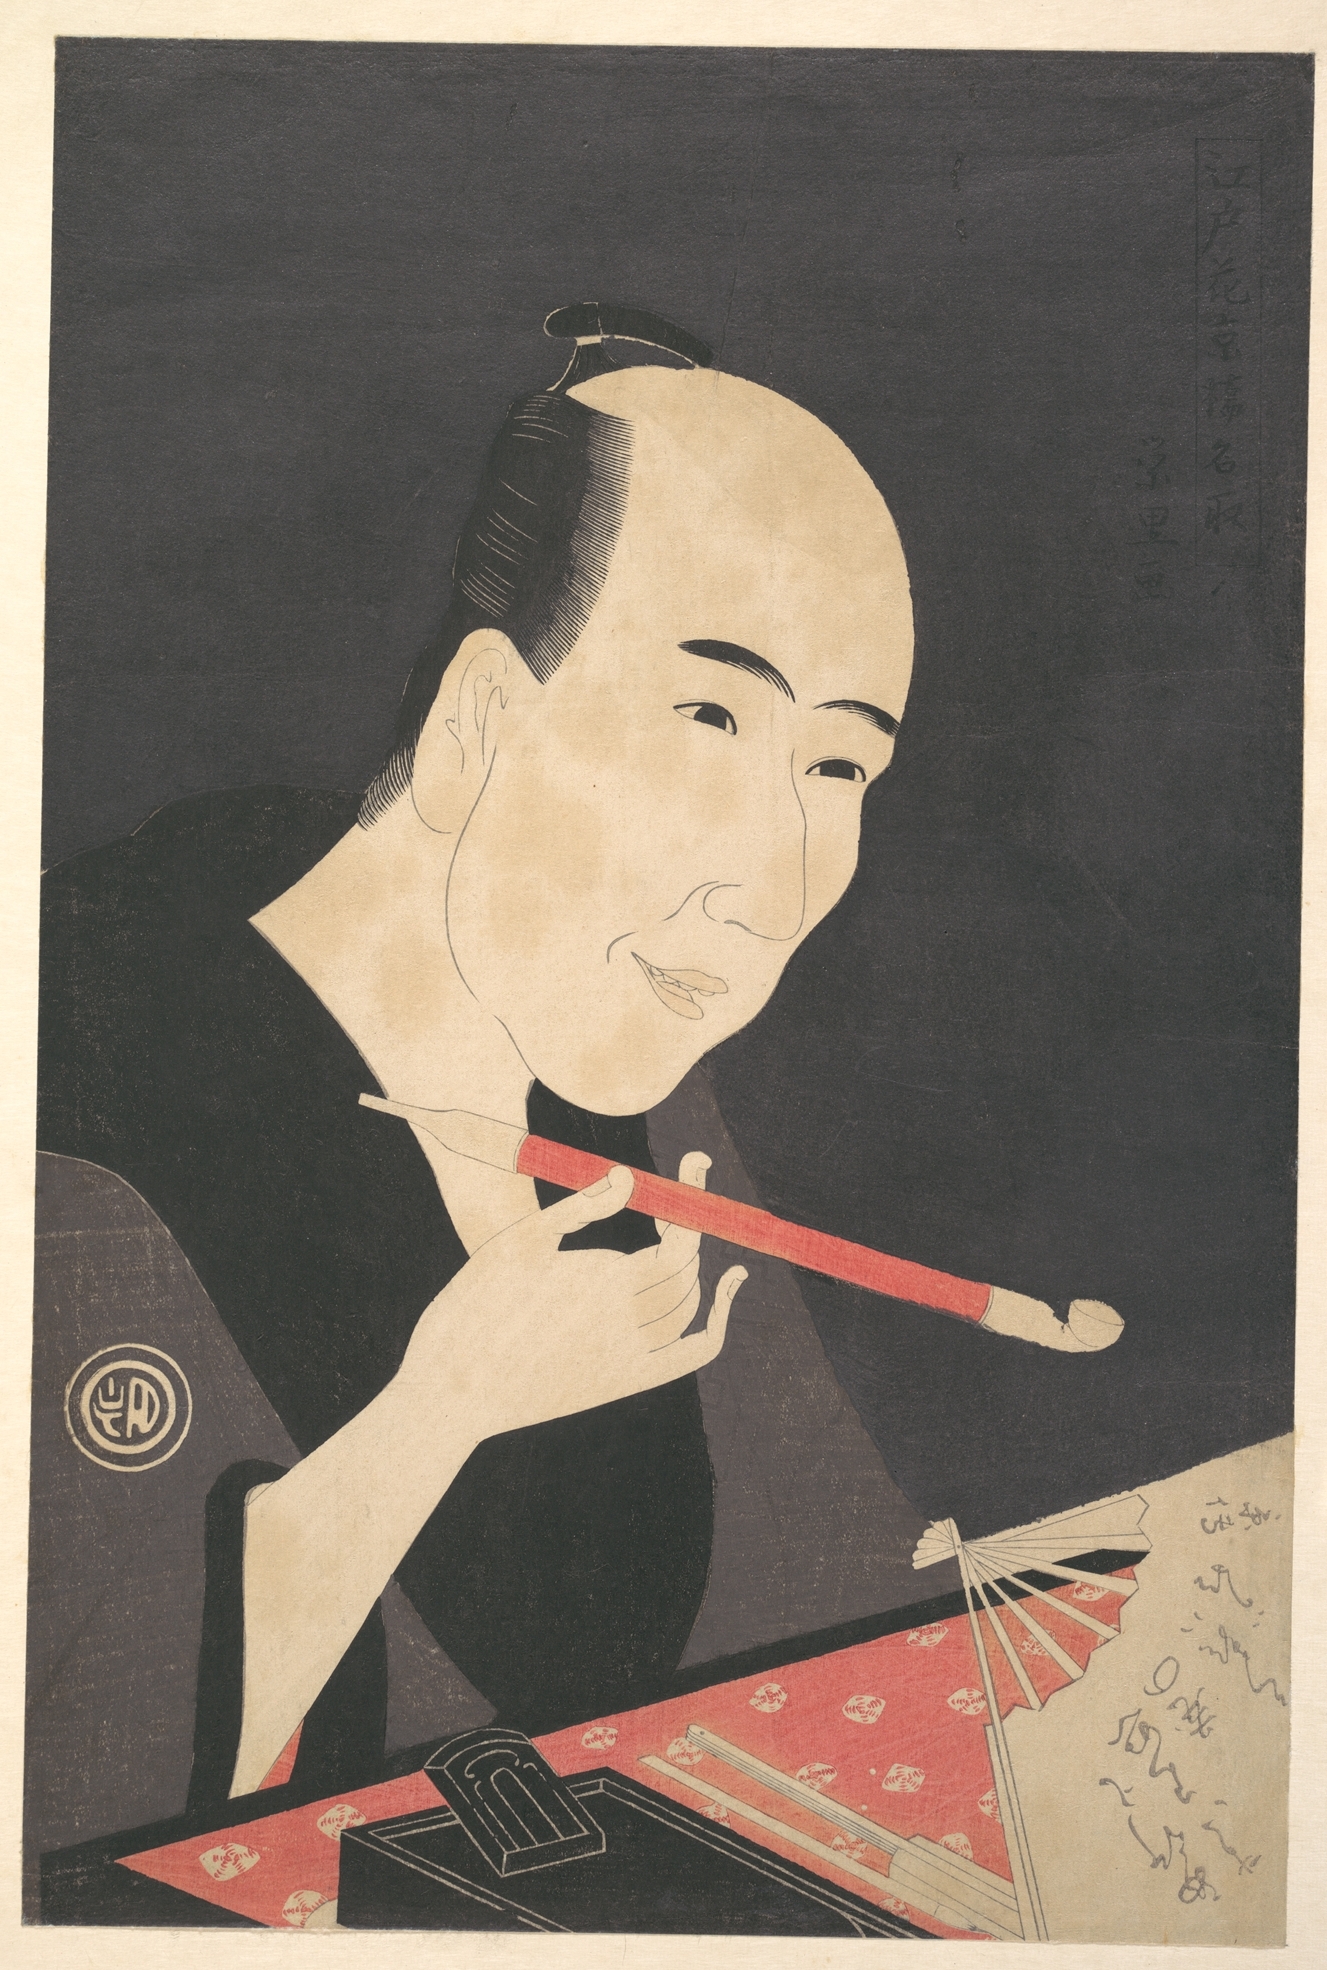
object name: print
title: The Writer Santō Kyōden (a.k.a. Kitao Masanobu)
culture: japanese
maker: chōkyōsai eiri 鳥橋斎栄里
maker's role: artist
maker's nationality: japanese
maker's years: 1789-1801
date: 1795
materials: ink, paper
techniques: woodblock print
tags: fans,men,pipes